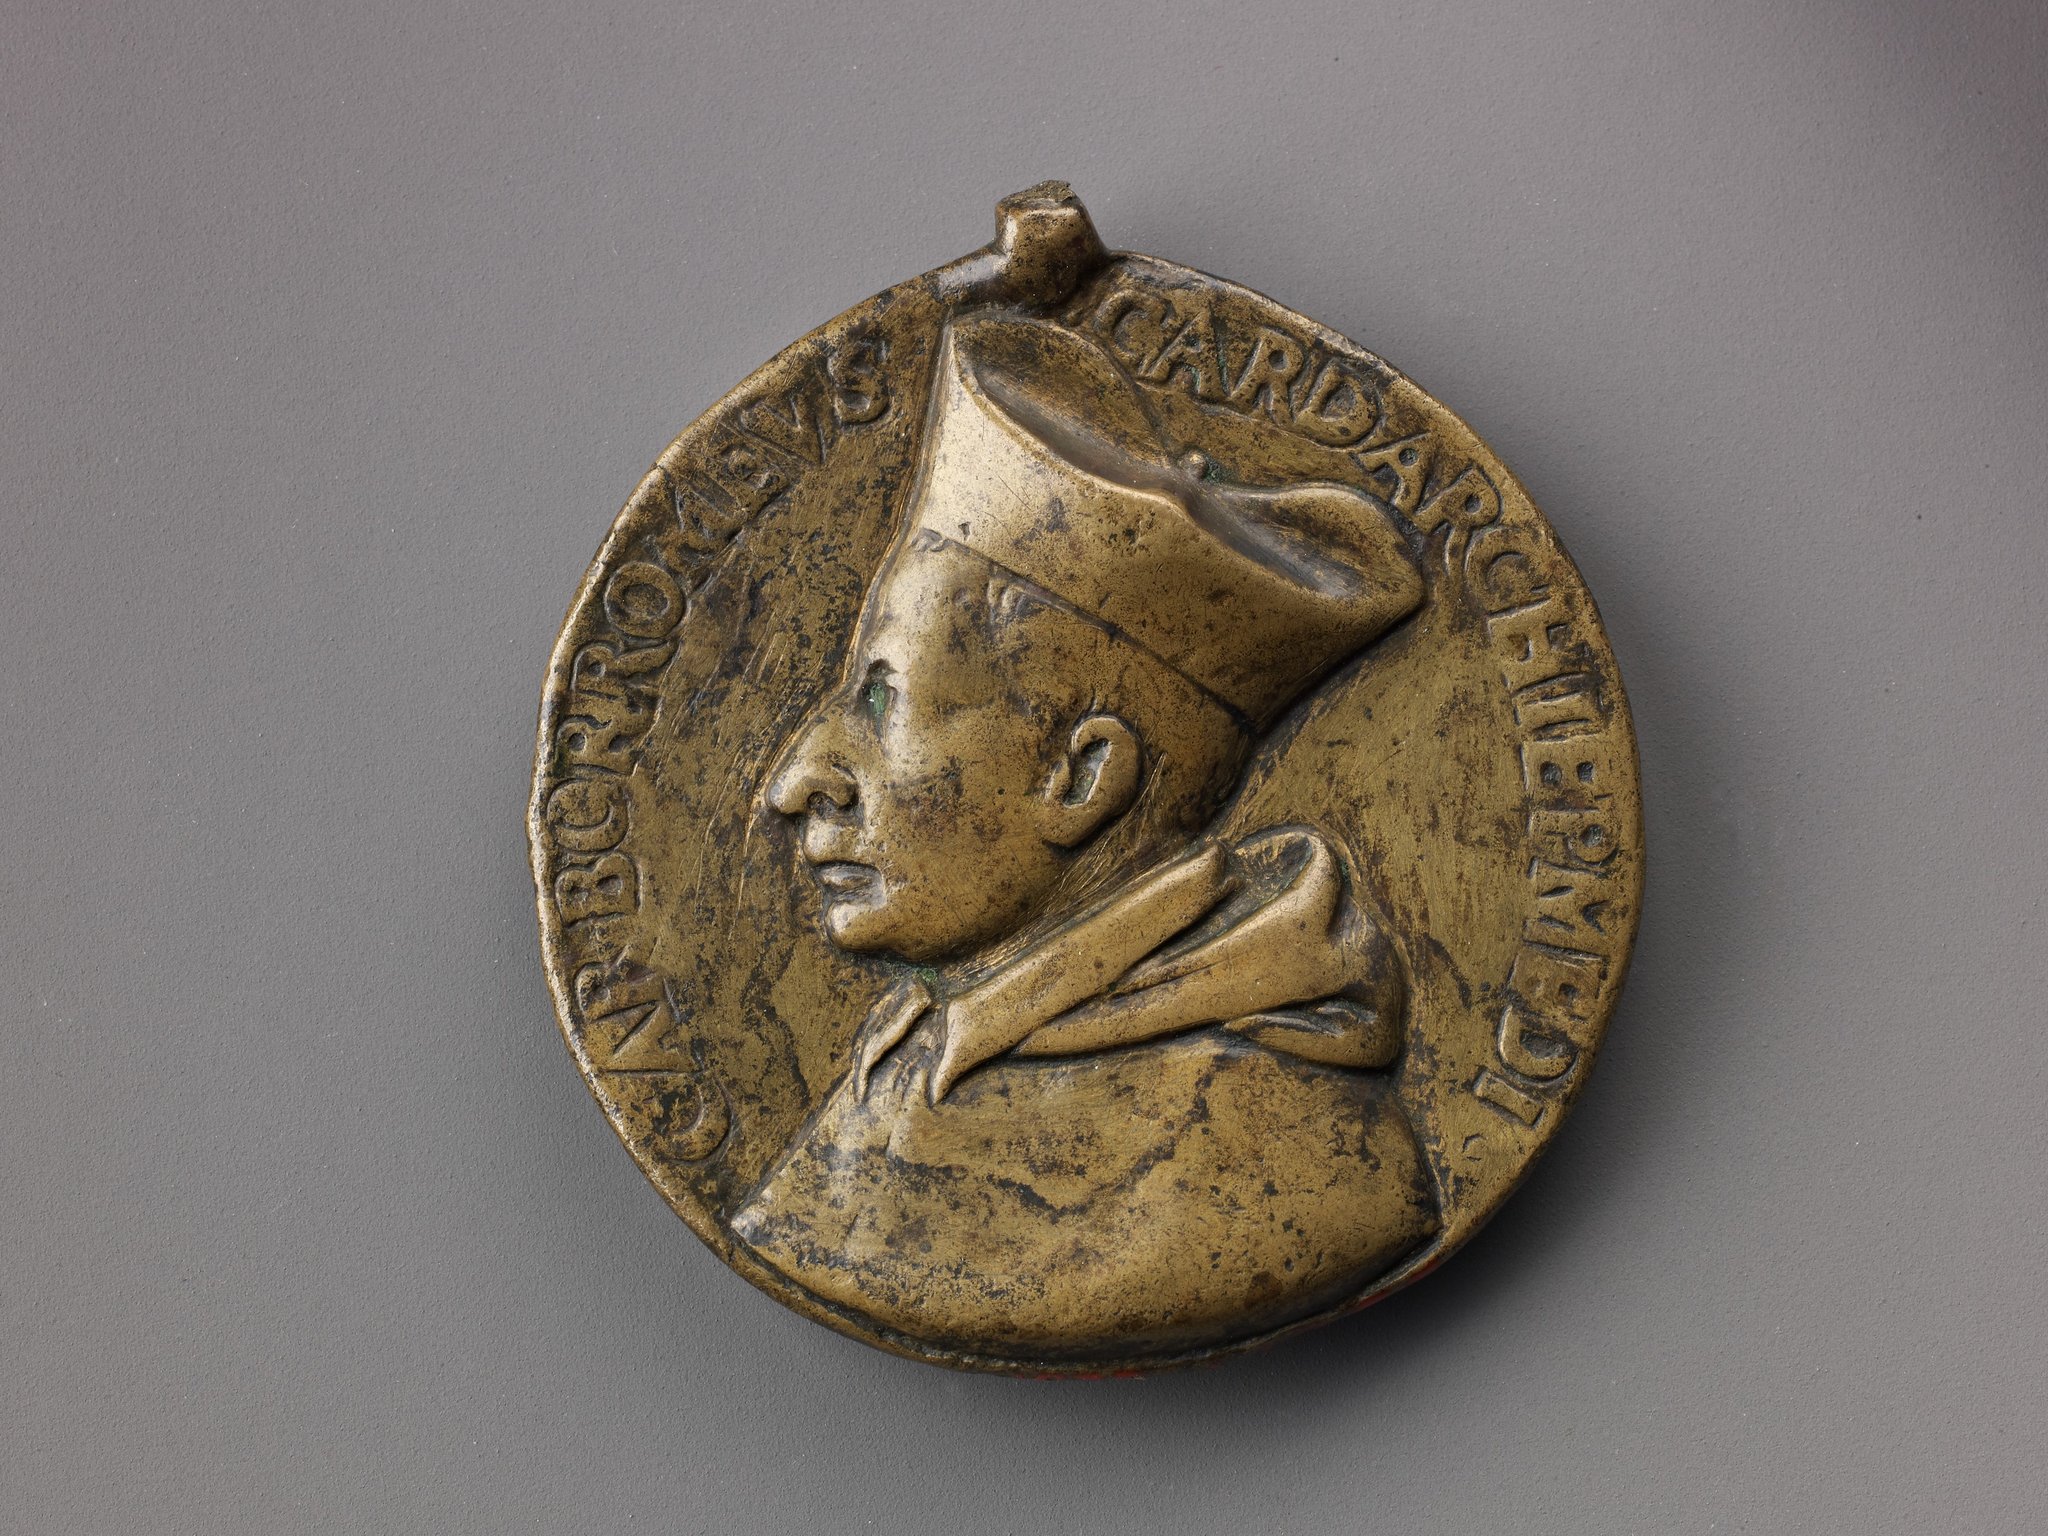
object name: medal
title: Medal: Bust of Carlo Borromeo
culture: italian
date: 1600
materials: bronze, copper alloy, patina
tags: men,portraits,profiles,lambs